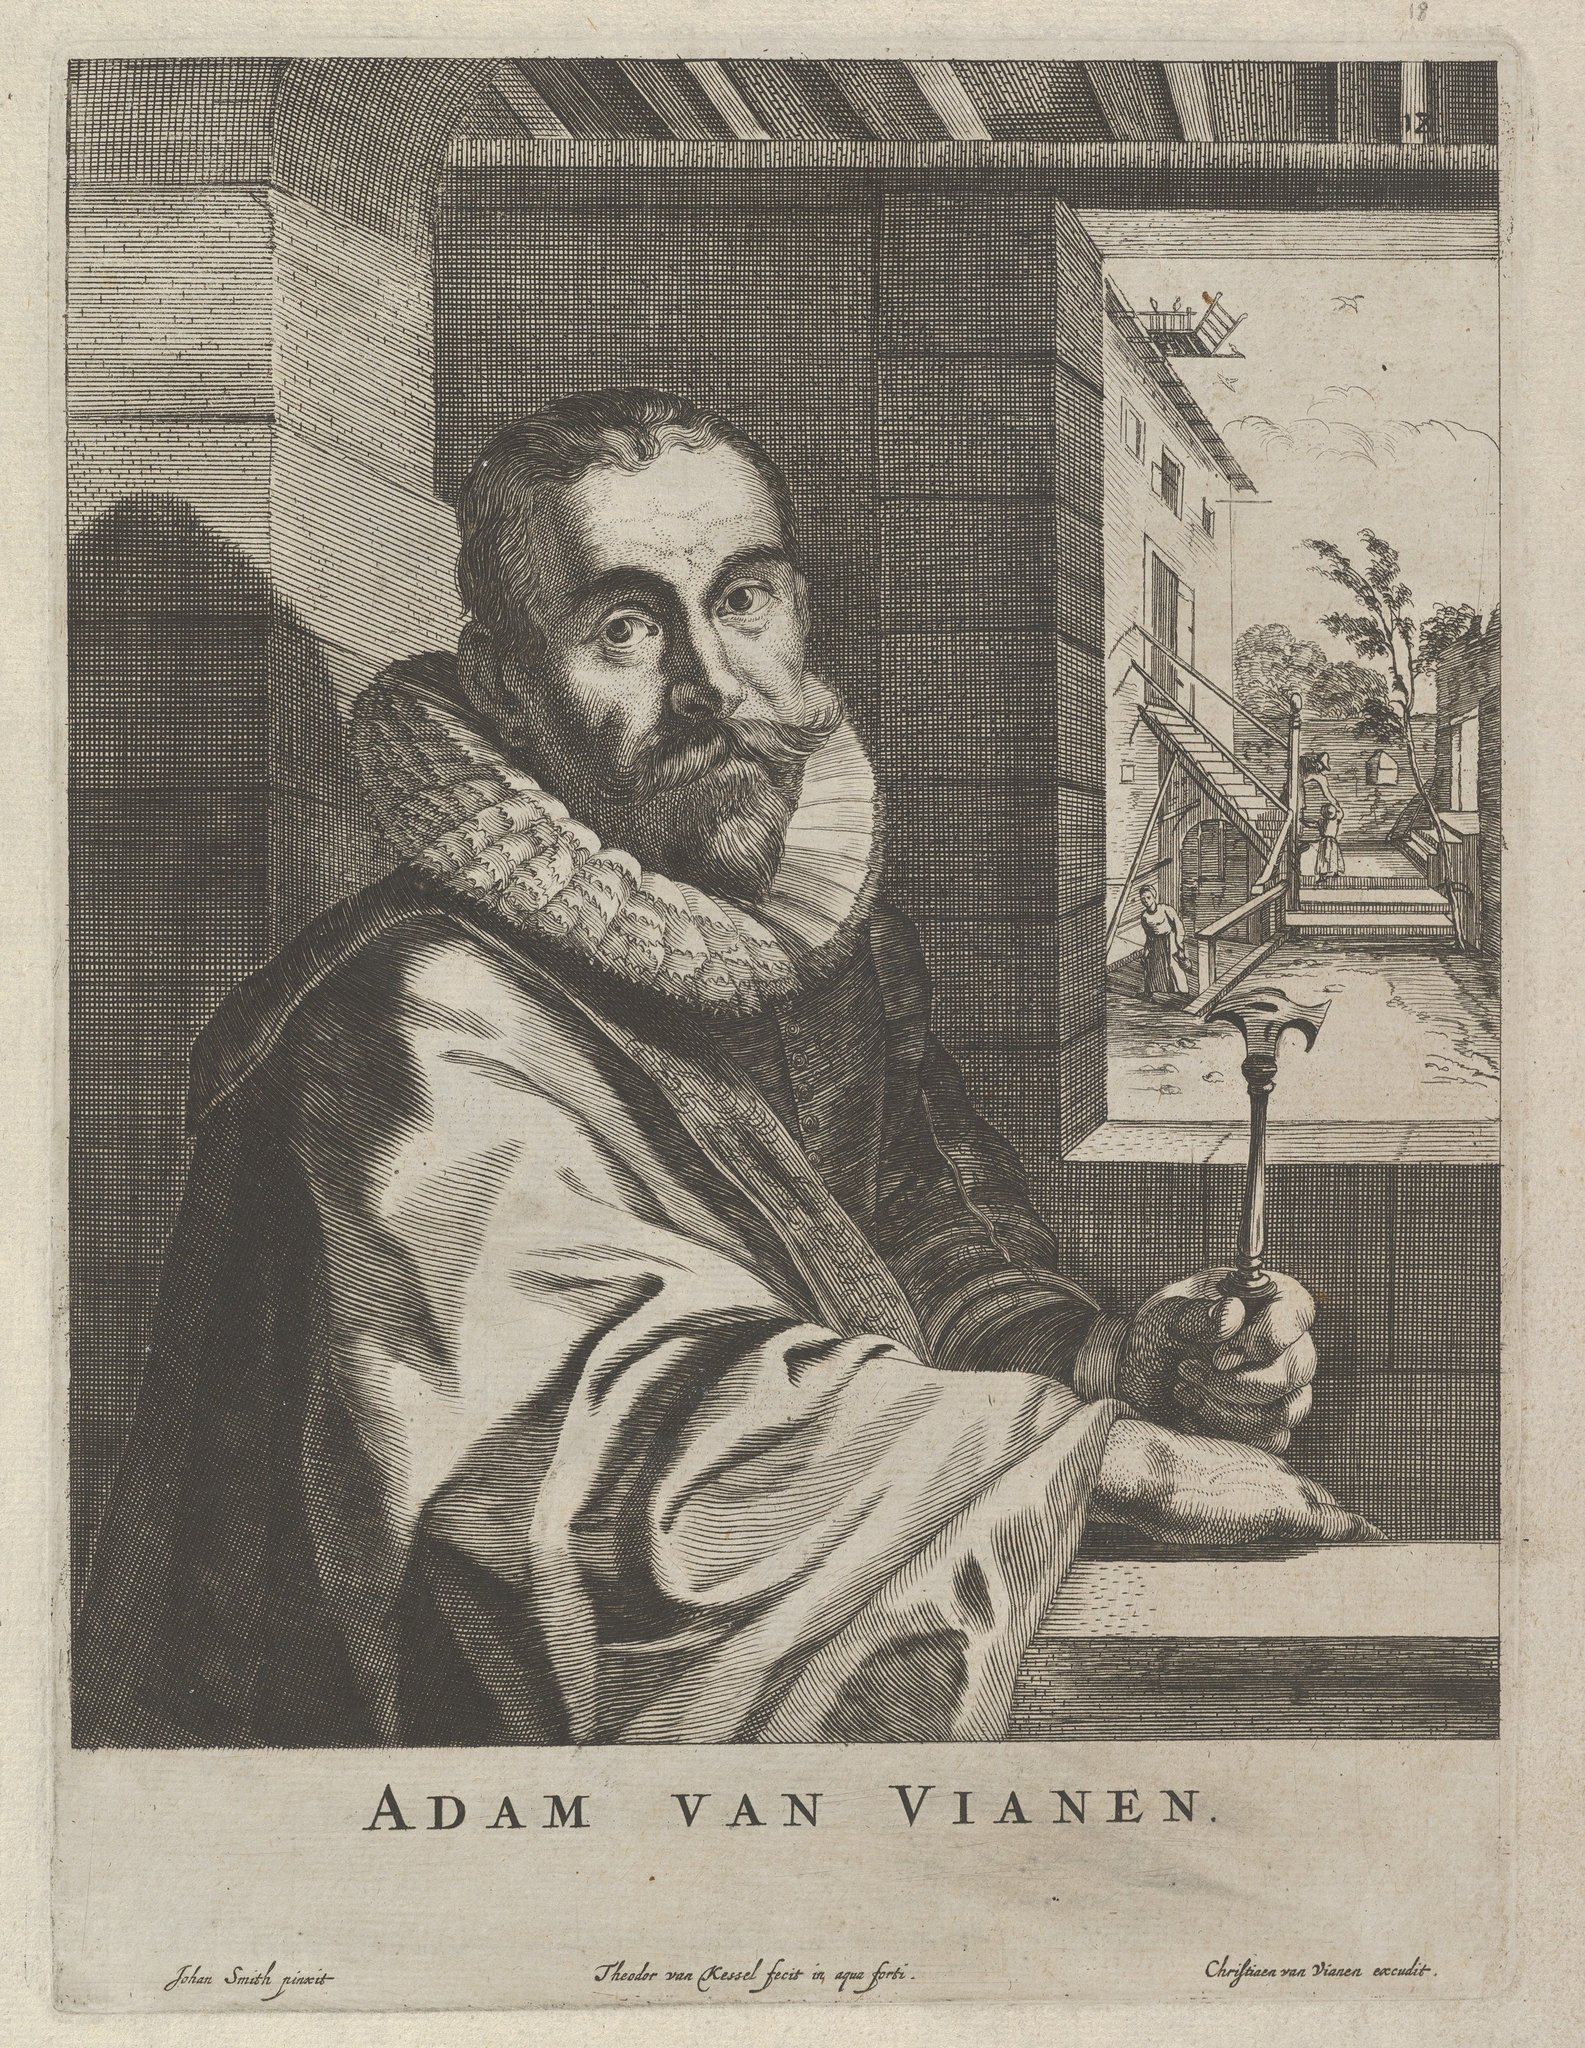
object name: album print ornament architecture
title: Portrait of Adam van Vianen, plate 18 from "Modelli Artificiosi (...), parte seconda"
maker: theodor van kessel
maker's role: etcher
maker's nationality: dutch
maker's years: 1620-1660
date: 1646-1652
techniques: etching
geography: netherlands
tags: men,portraits